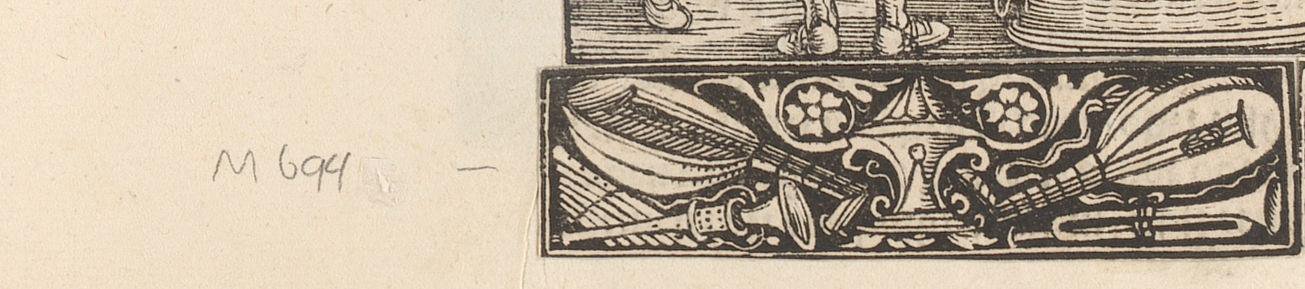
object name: album leaf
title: Vaas met aan weerszijden een luit en een trompet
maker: Anonymous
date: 1514-1532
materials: paper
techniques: letterpress printing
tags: horn, trumpet, cornet, trombone, tuba, vase ~ ornament, lute, and special forms of lute, e.g.: theorbo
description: Deze prent is gebruikt als ornament in: Petrarca, Francesco. Von der Artzney bayder Glück, des guten und widerwertigen: unnd weß sich ain yeder inn Gelück und Unglück halten sol (...). Augsburg: Heinrich Steiner, 1532. Deze uitgave is ook bekend onder de titel 'Trostspiegel in Glück und Unglück'.